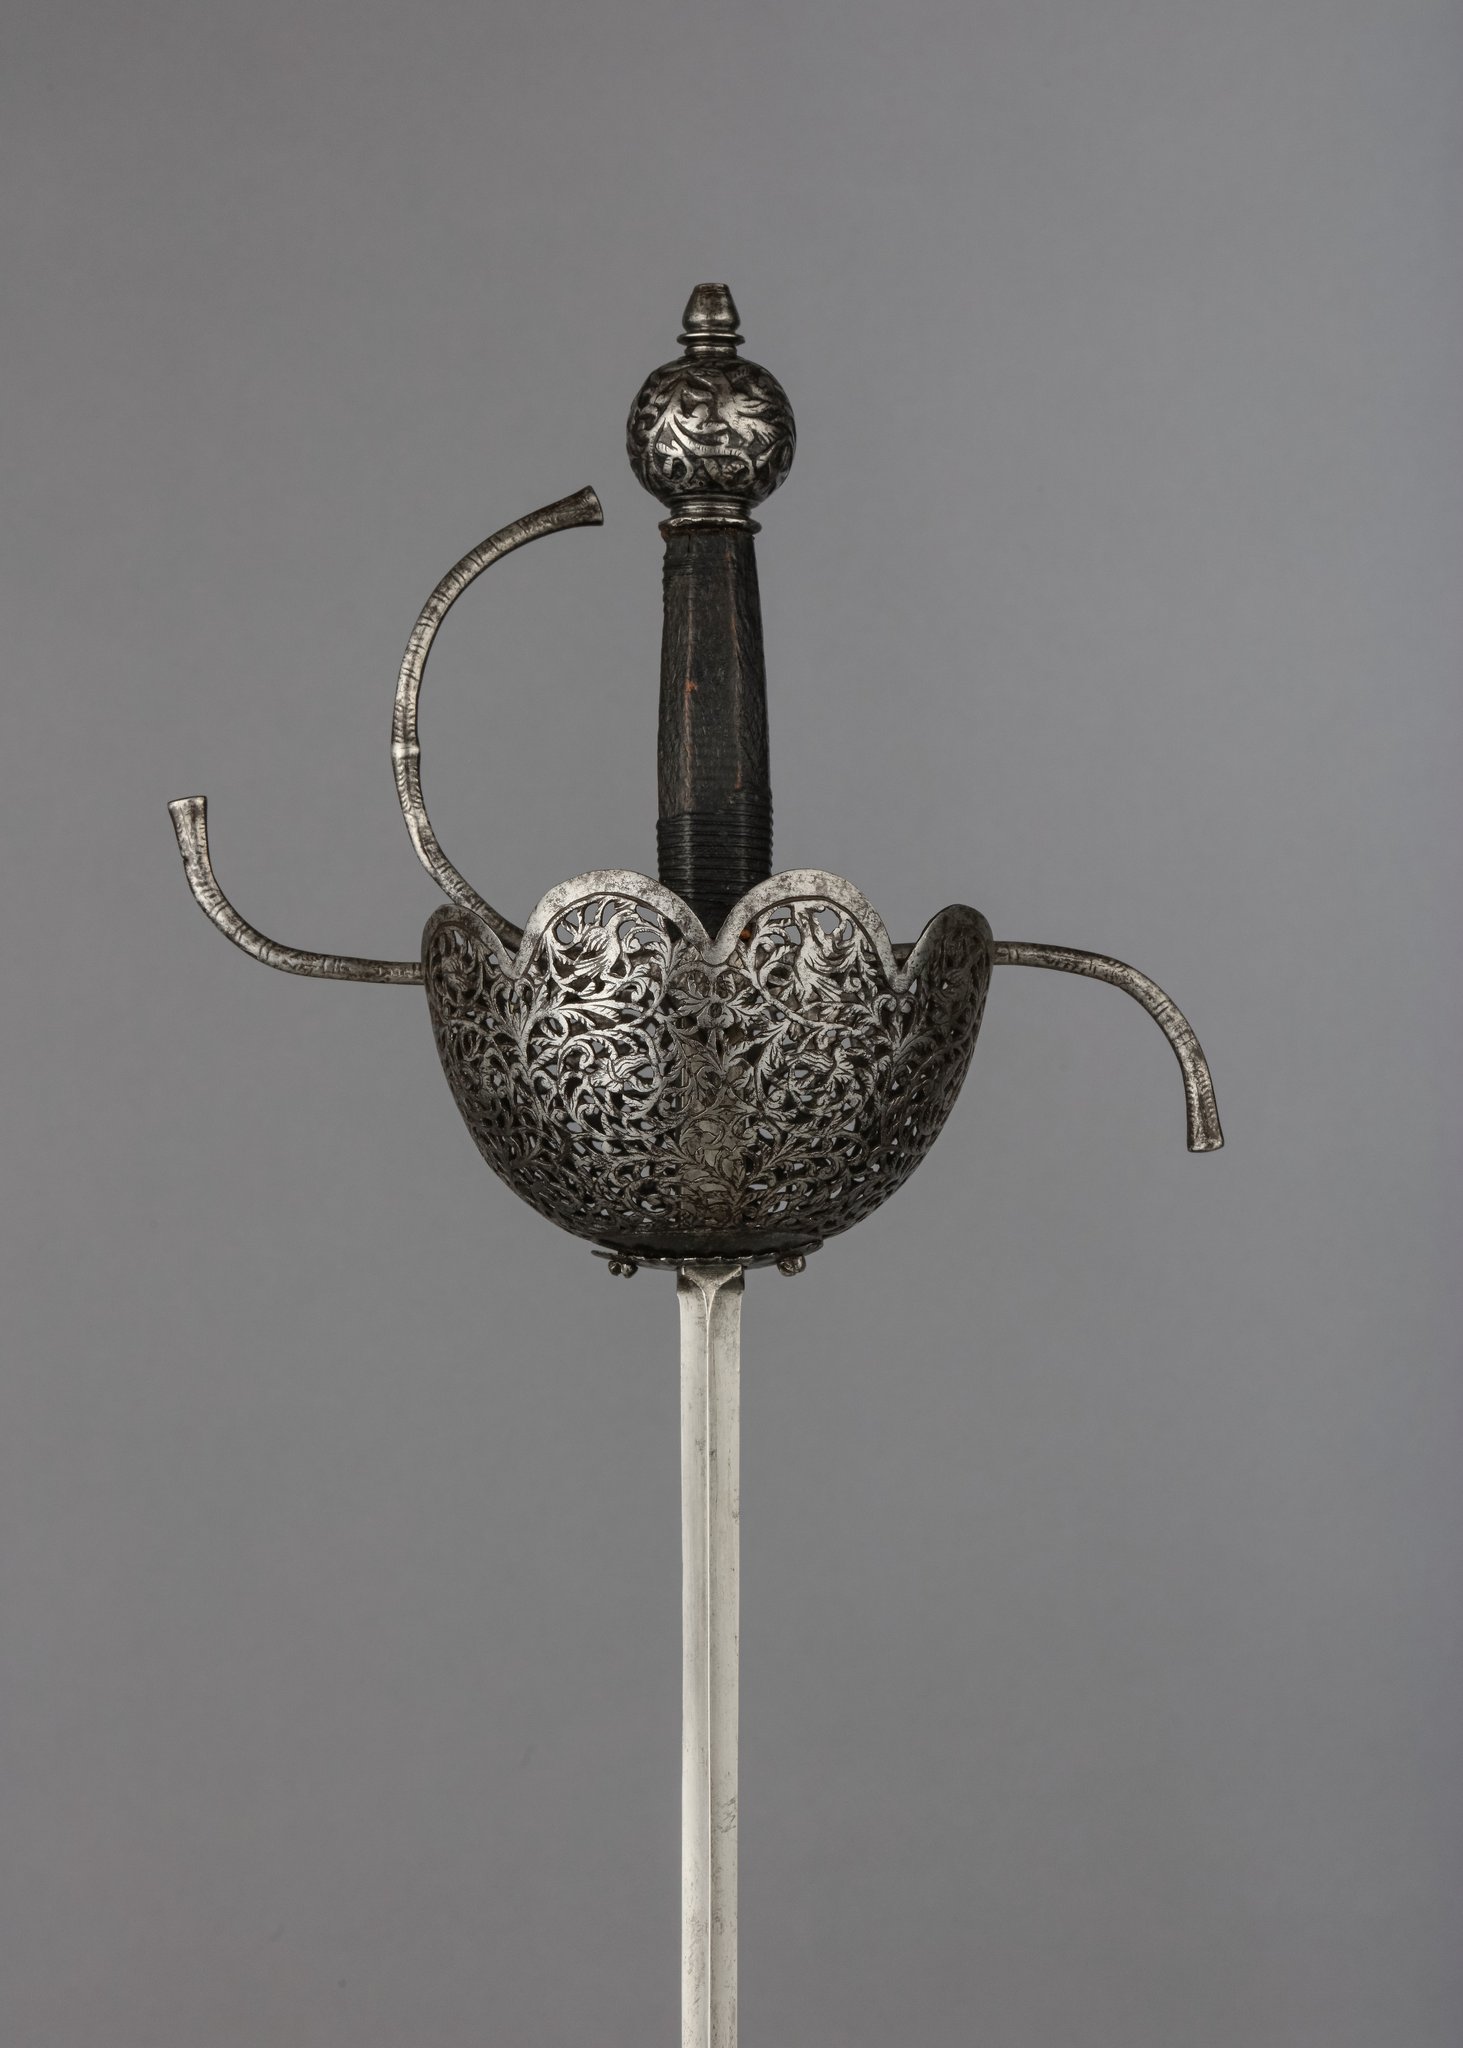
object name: cup hilted rapier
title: Cup-Hilted Rapier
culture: italian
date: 1650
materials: steel, wood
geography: italy